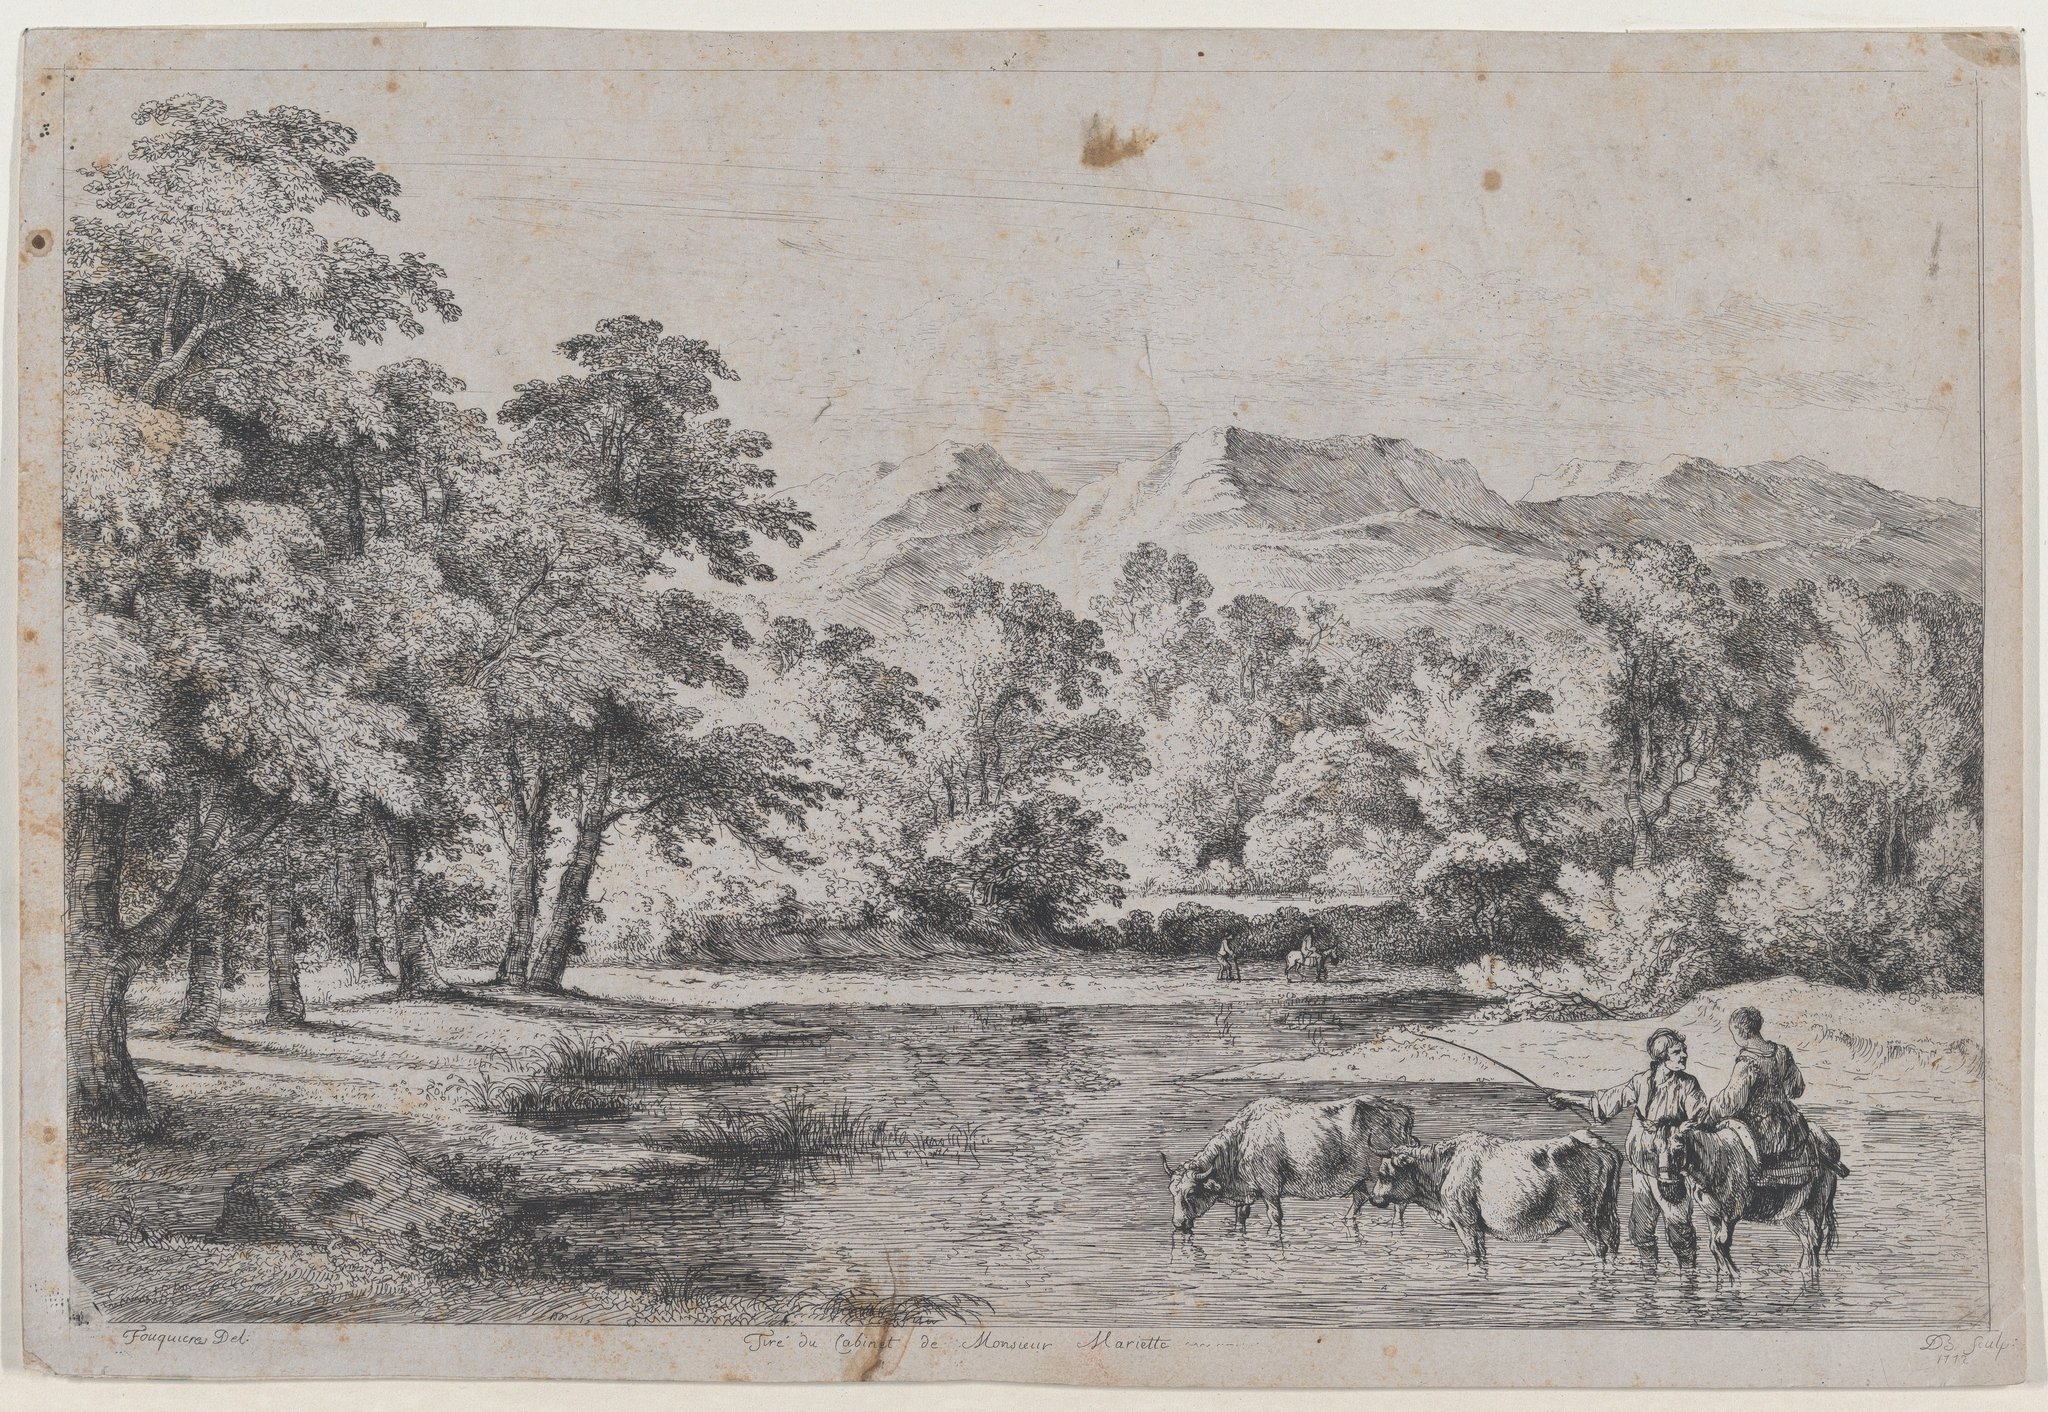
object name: print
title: Landscape after Fouquières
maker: jean jacques de boissieu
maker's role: artist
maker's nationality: french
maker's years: 1736-1810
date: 1772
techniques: etching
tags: men,cows,landscapes